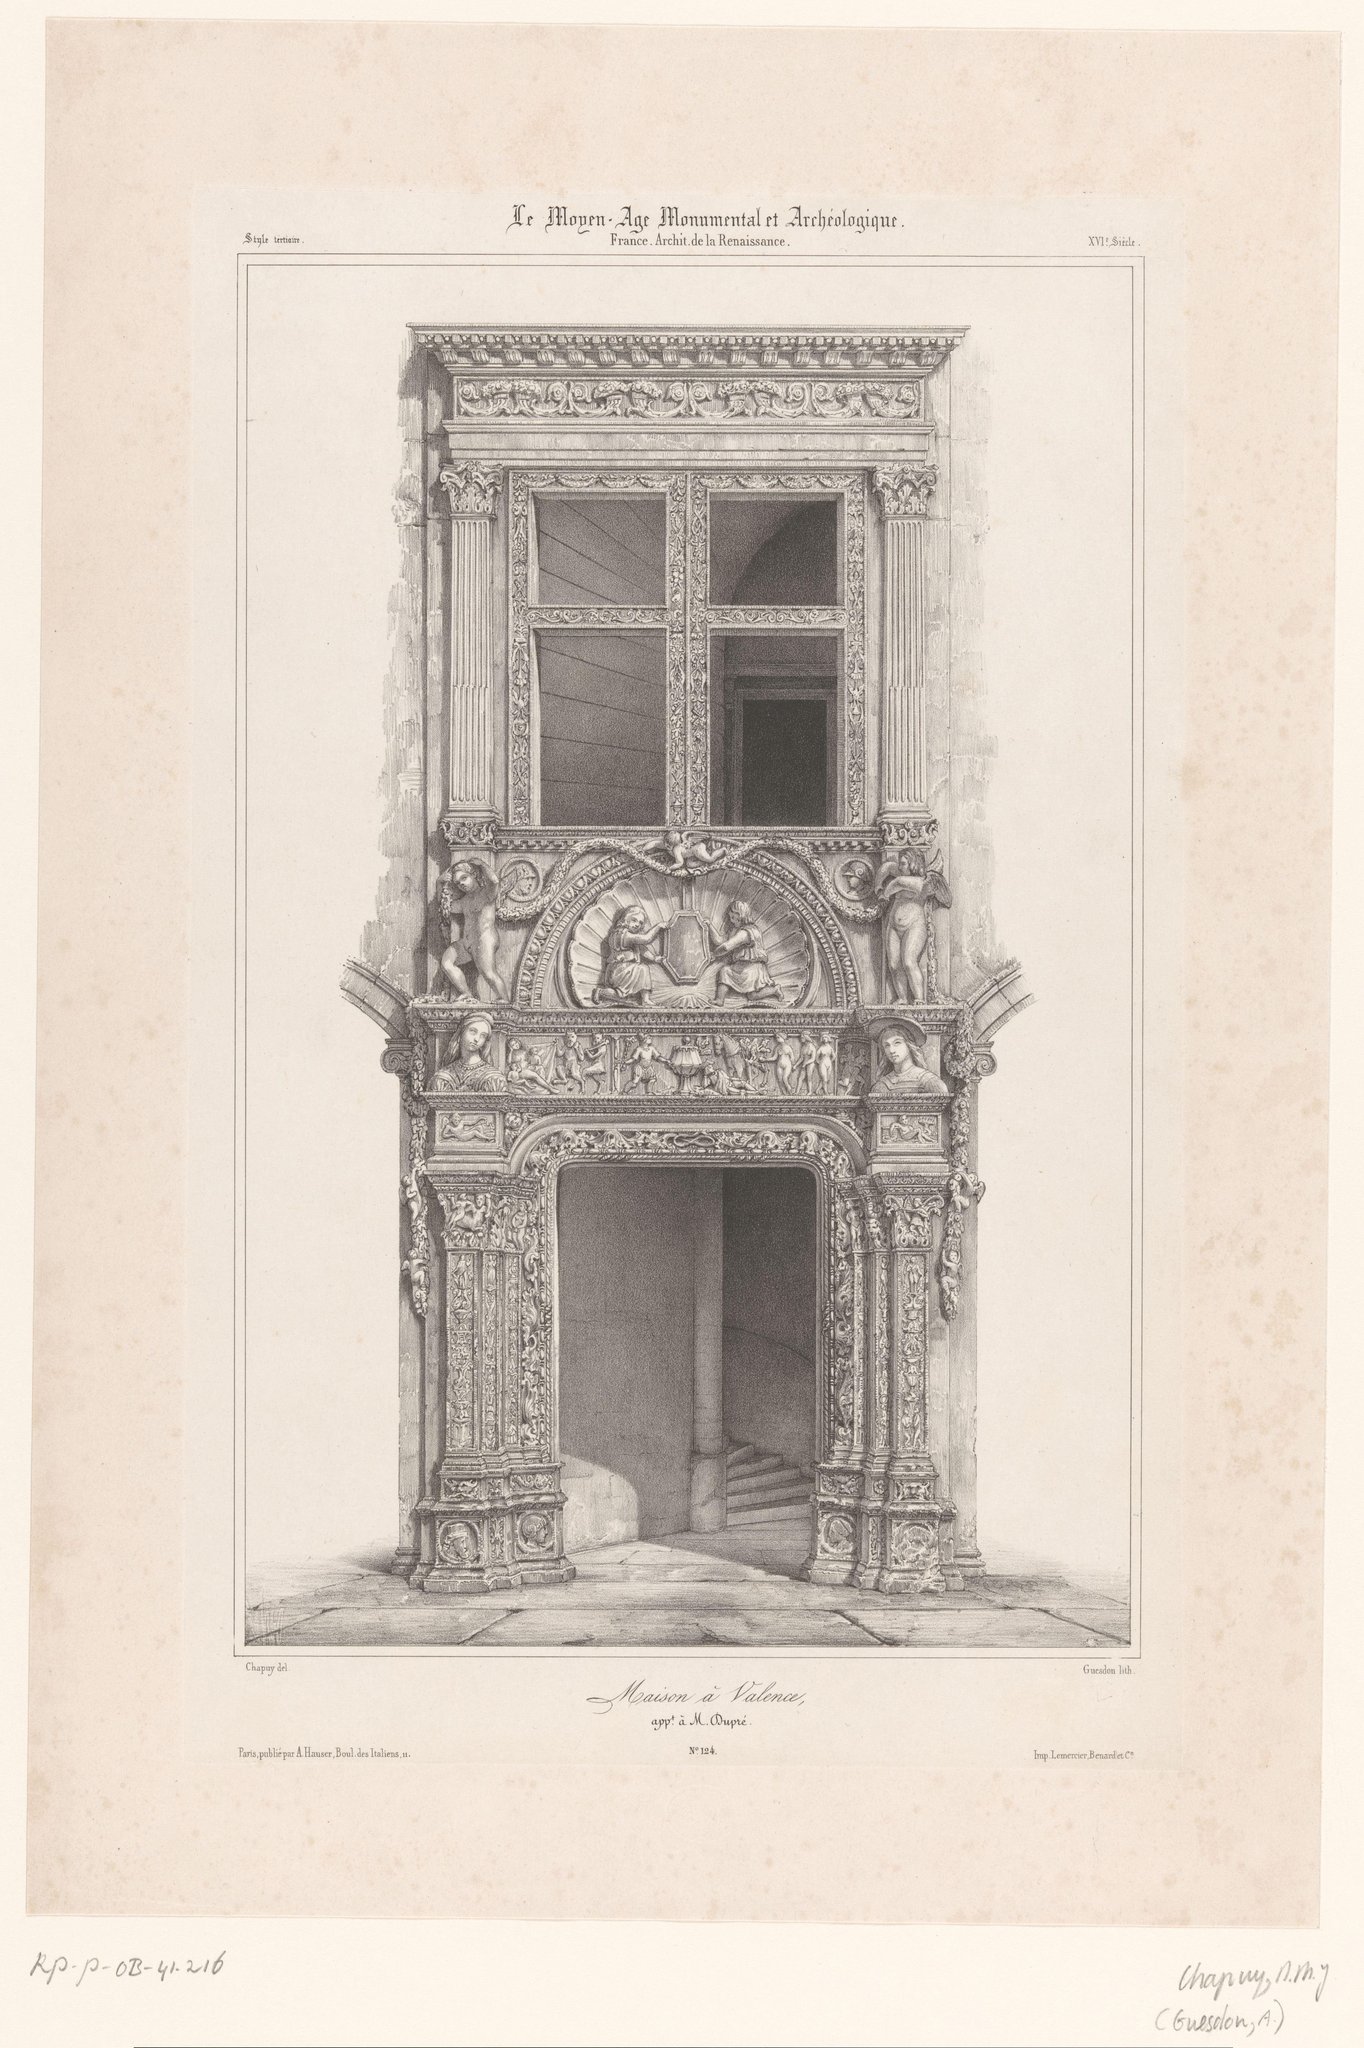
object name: print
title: Le Moyen-Age monumental et archéologique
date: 1840-1851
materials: paper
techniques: lithograph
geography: paris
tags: gate, entrance, hôtel, i.e. small palace in city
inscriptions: check stamp: Lugt 4210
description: Deze serie bestaat uit in ieder geval 431 en mogelijk meer prenten. De serie werd in verschillende 'livraisons' uitgegeven tussen 1840 en 1851. Gebaseerd op vermeldingen in 'Bibliographie de la France' (via http://artfl-project.uchicago.edu/content/image-france).